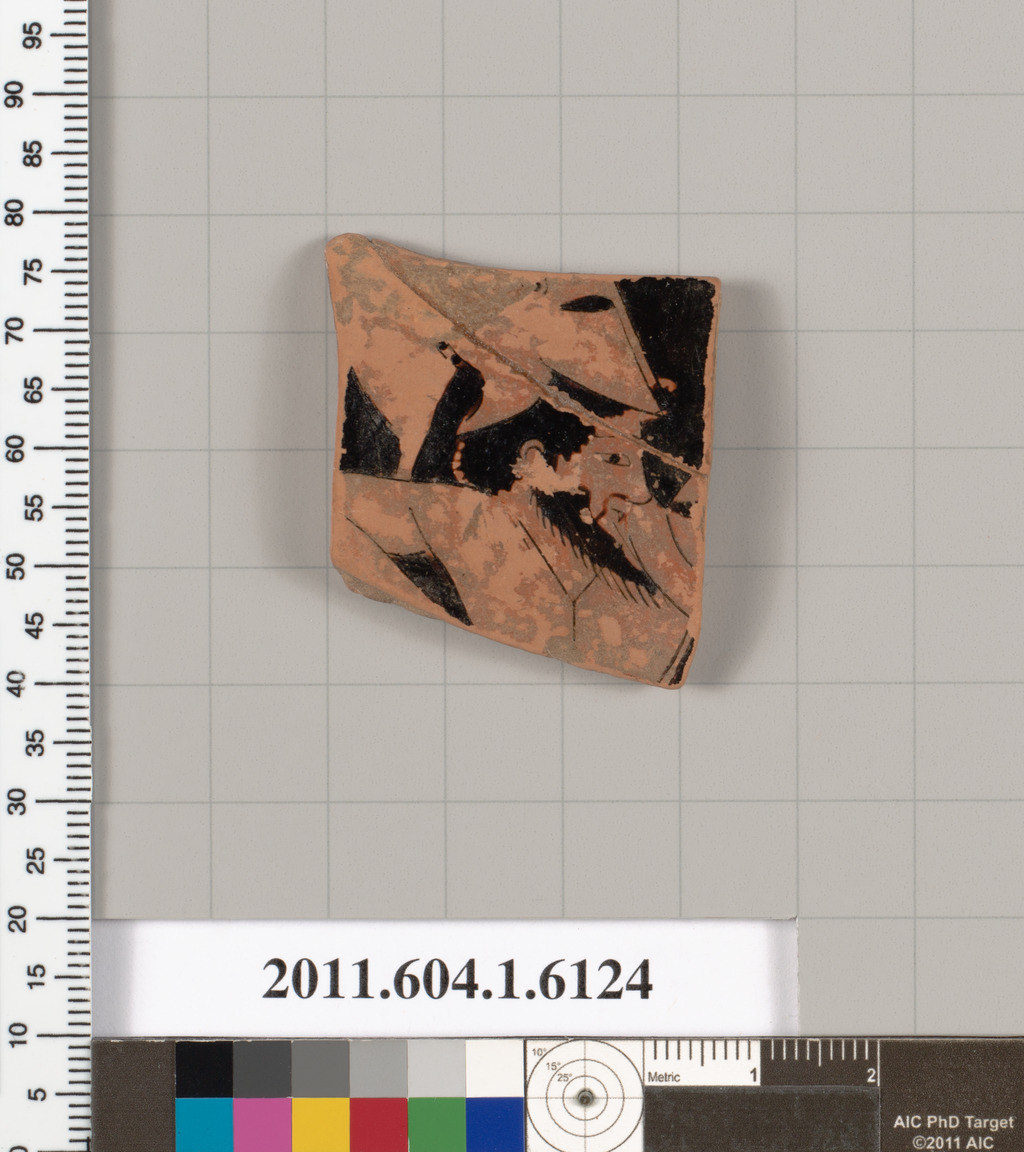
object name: kylix fragment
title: Terracotta fragment of a kylix (drinking cup)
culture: greek, attic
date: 520-500 BCE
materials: terracotta